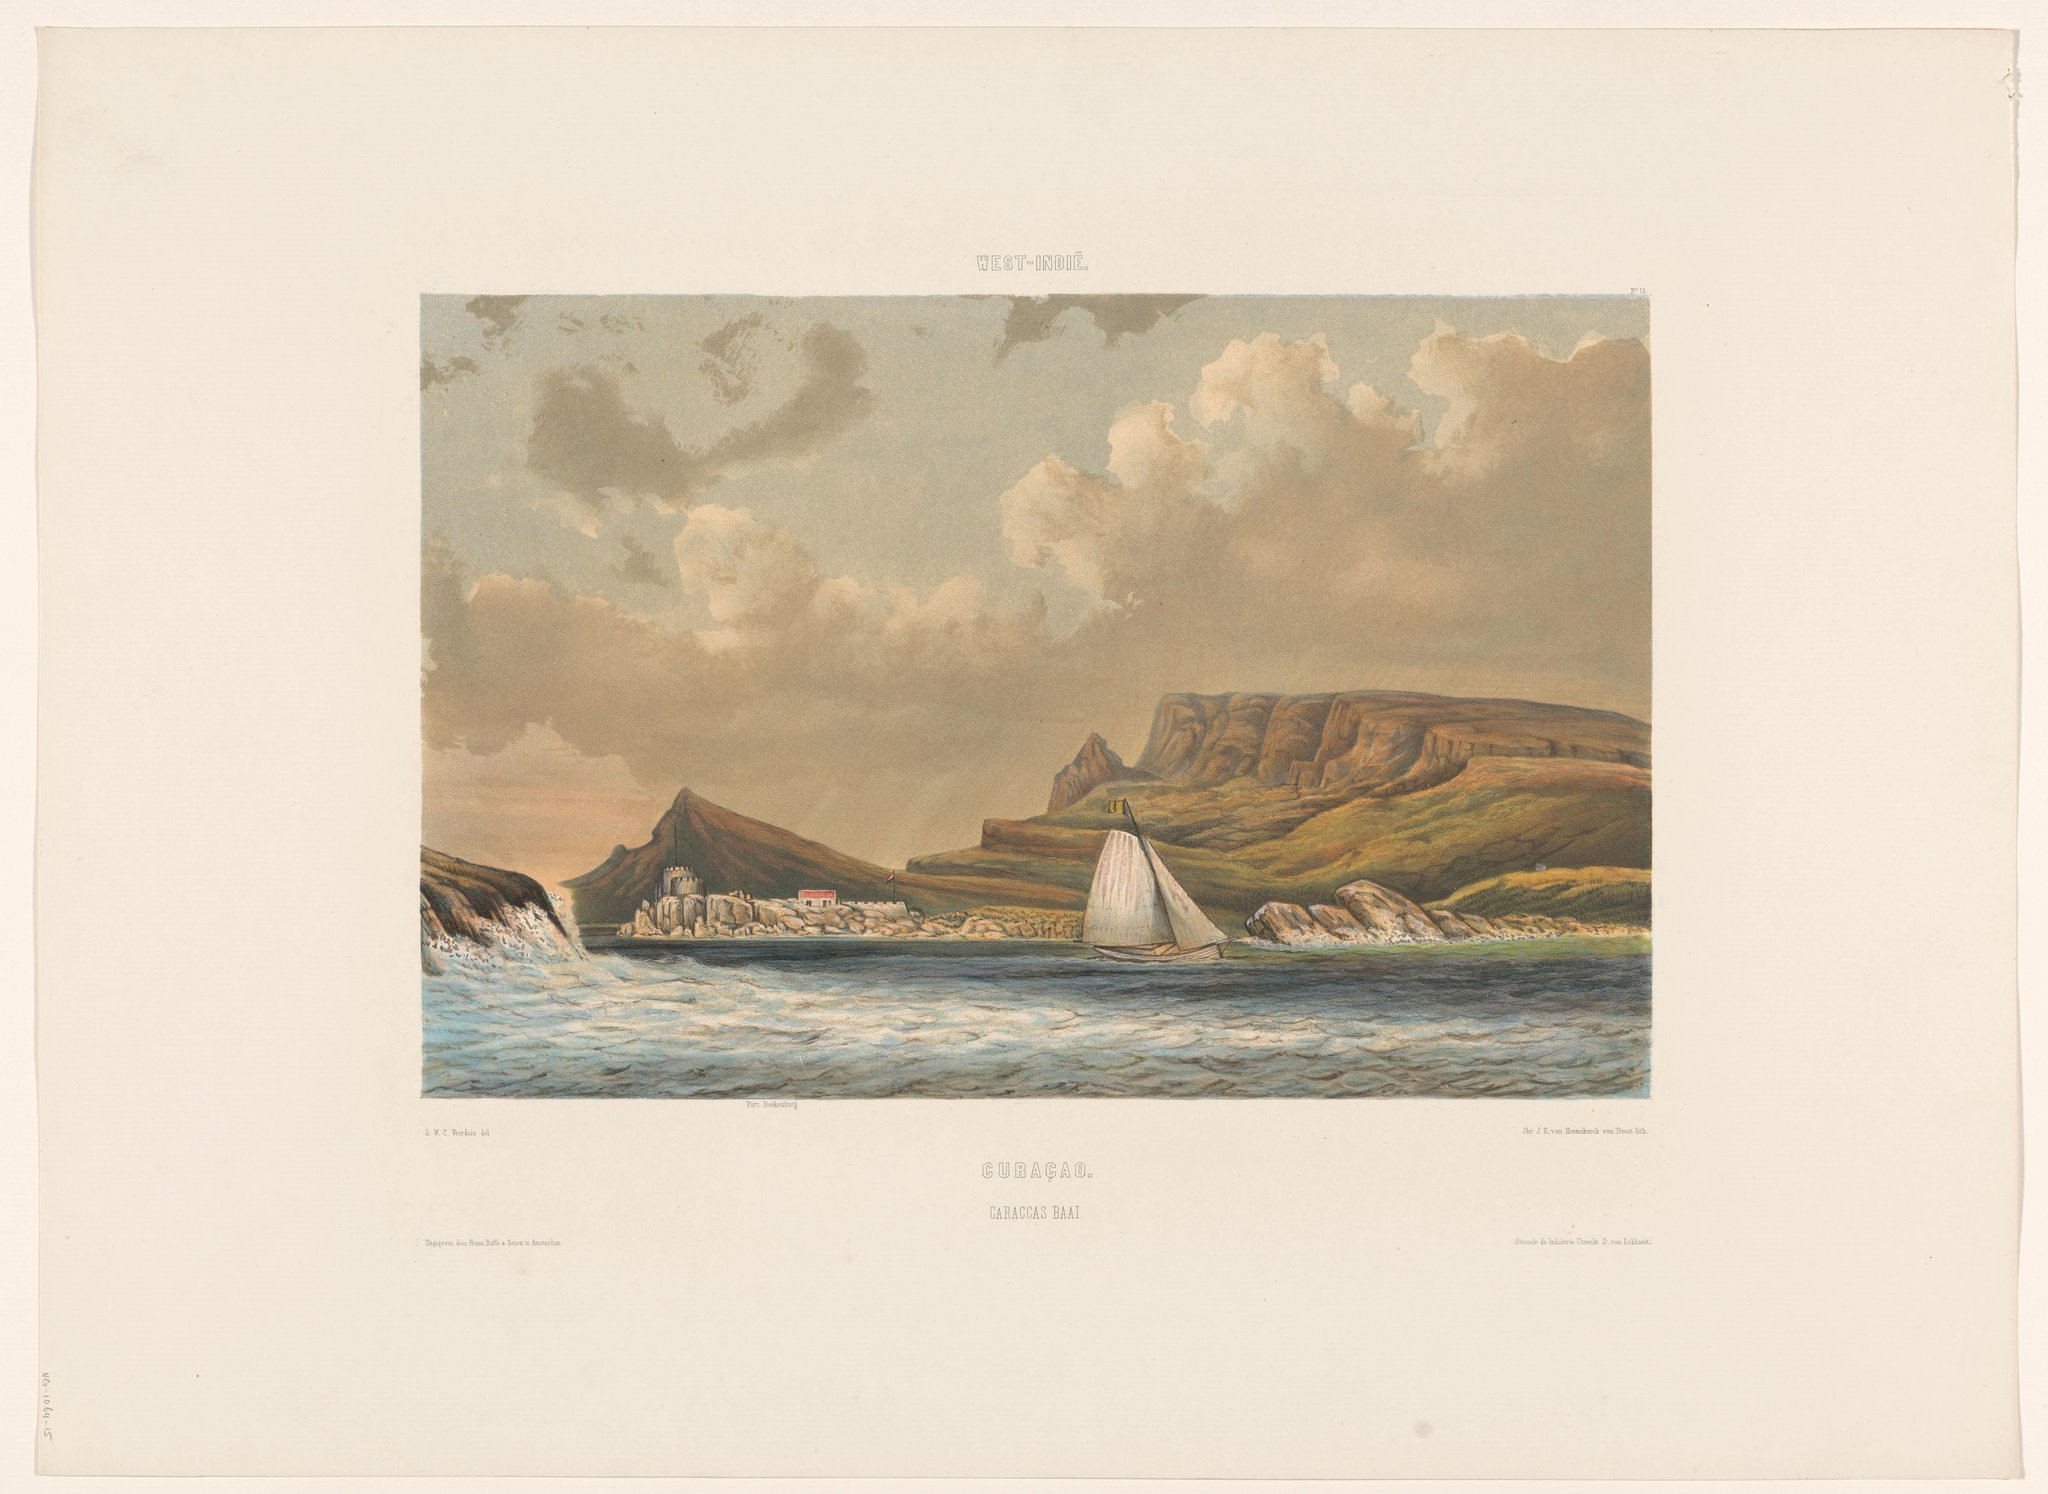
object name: print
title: Caracasbaai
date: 1860-1862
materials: paper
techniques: lithograph, hand coloring, lacquer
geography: amsterdam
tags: colonial system, gulf, bay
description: Gezicht op Caracasbaai bij Willemstad. Op de plaat staat verder aangegeven: Fort Beekenburg. Onderdeel van het plaatwerk 'Gezigten uit Neerland's West-Indien'.